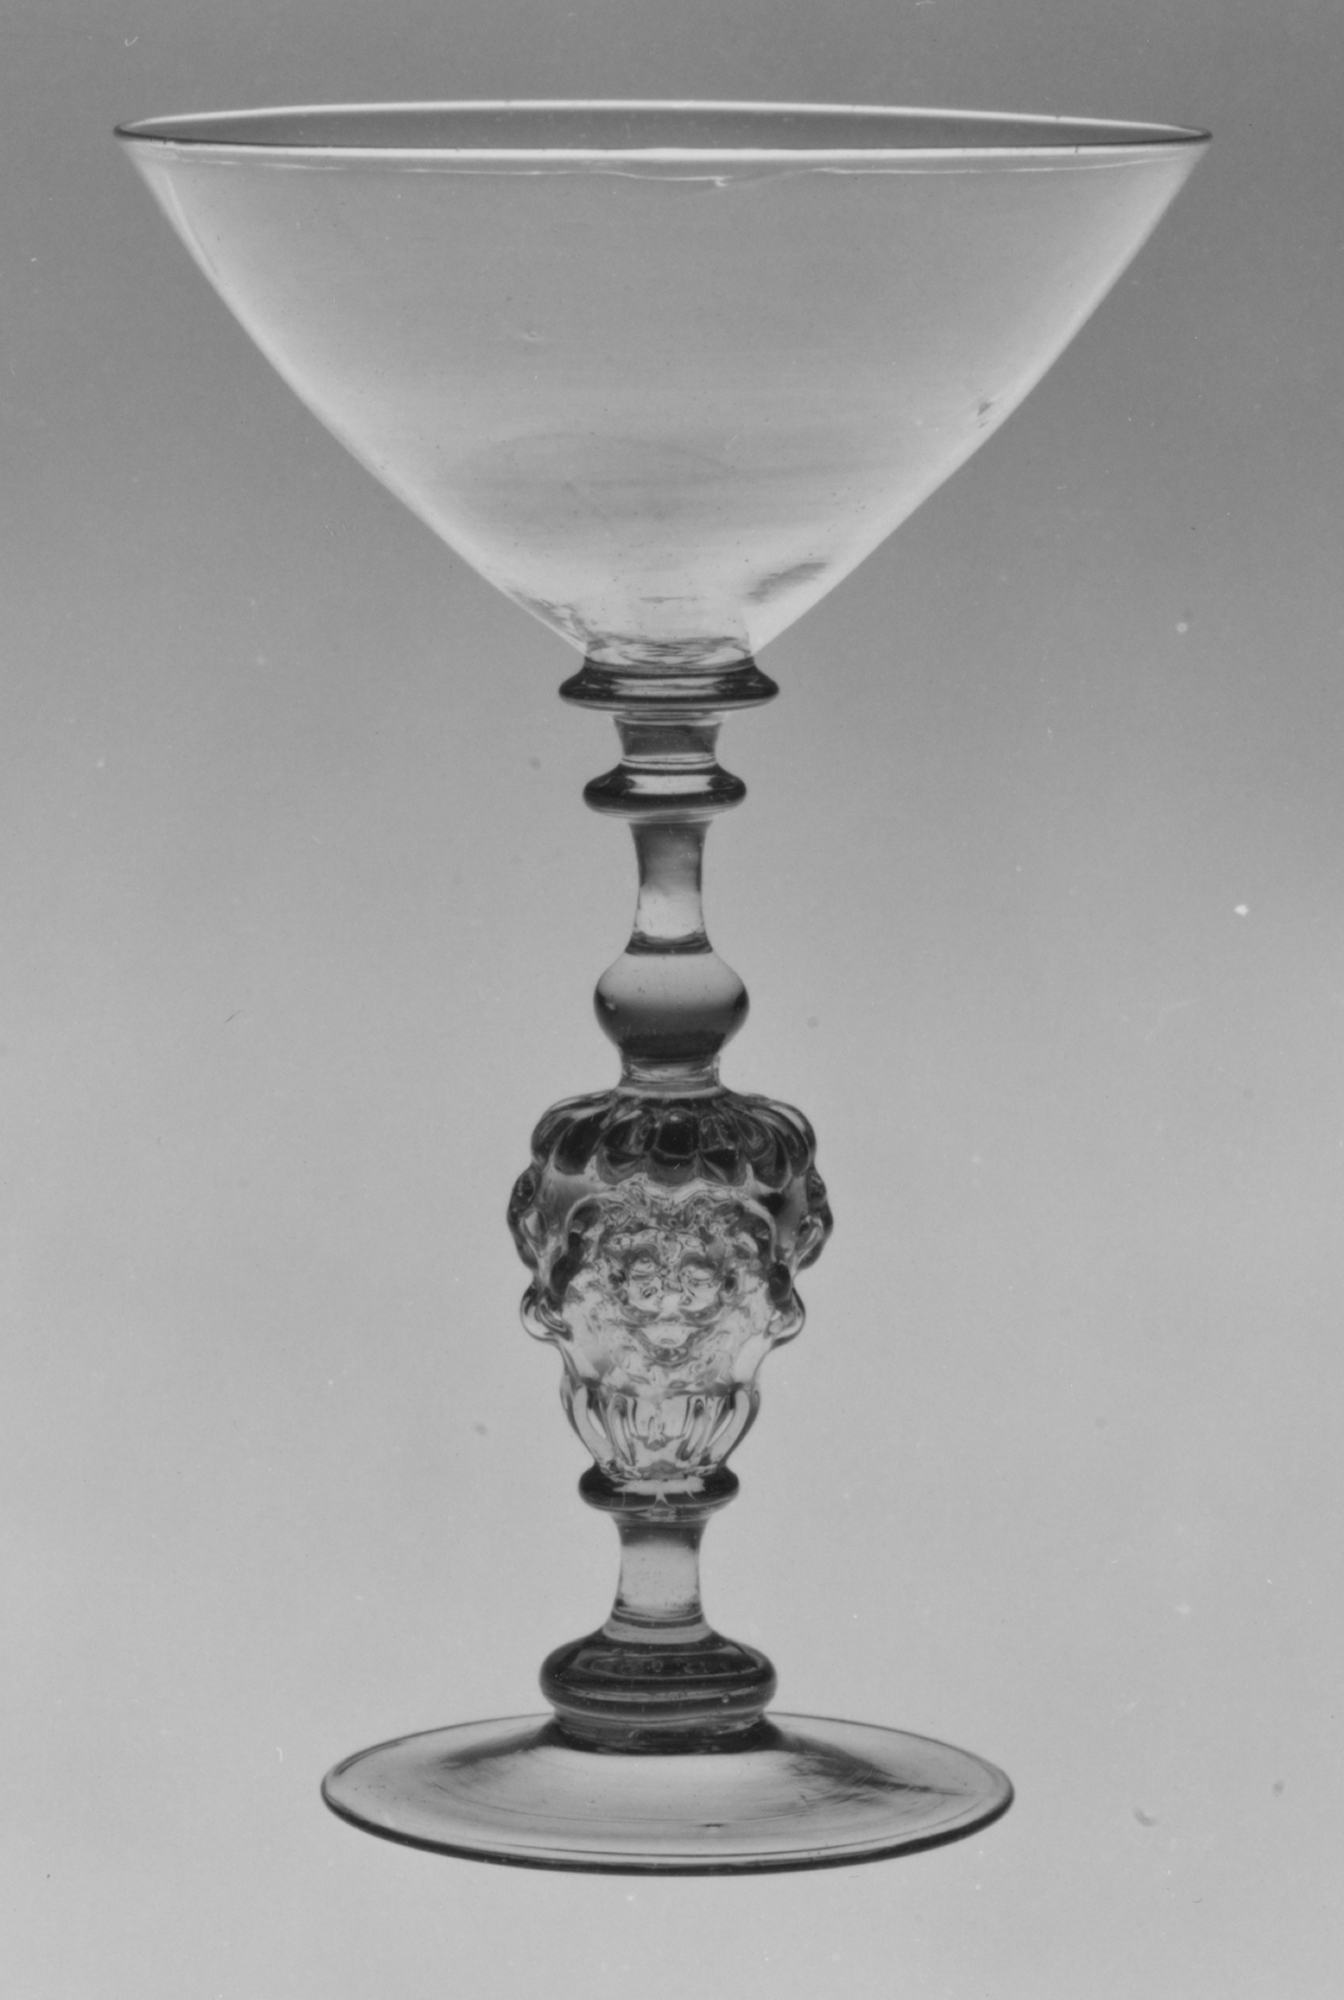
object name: wineglass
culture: façon de venise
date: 1501-1600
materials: glass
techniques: glassblowing